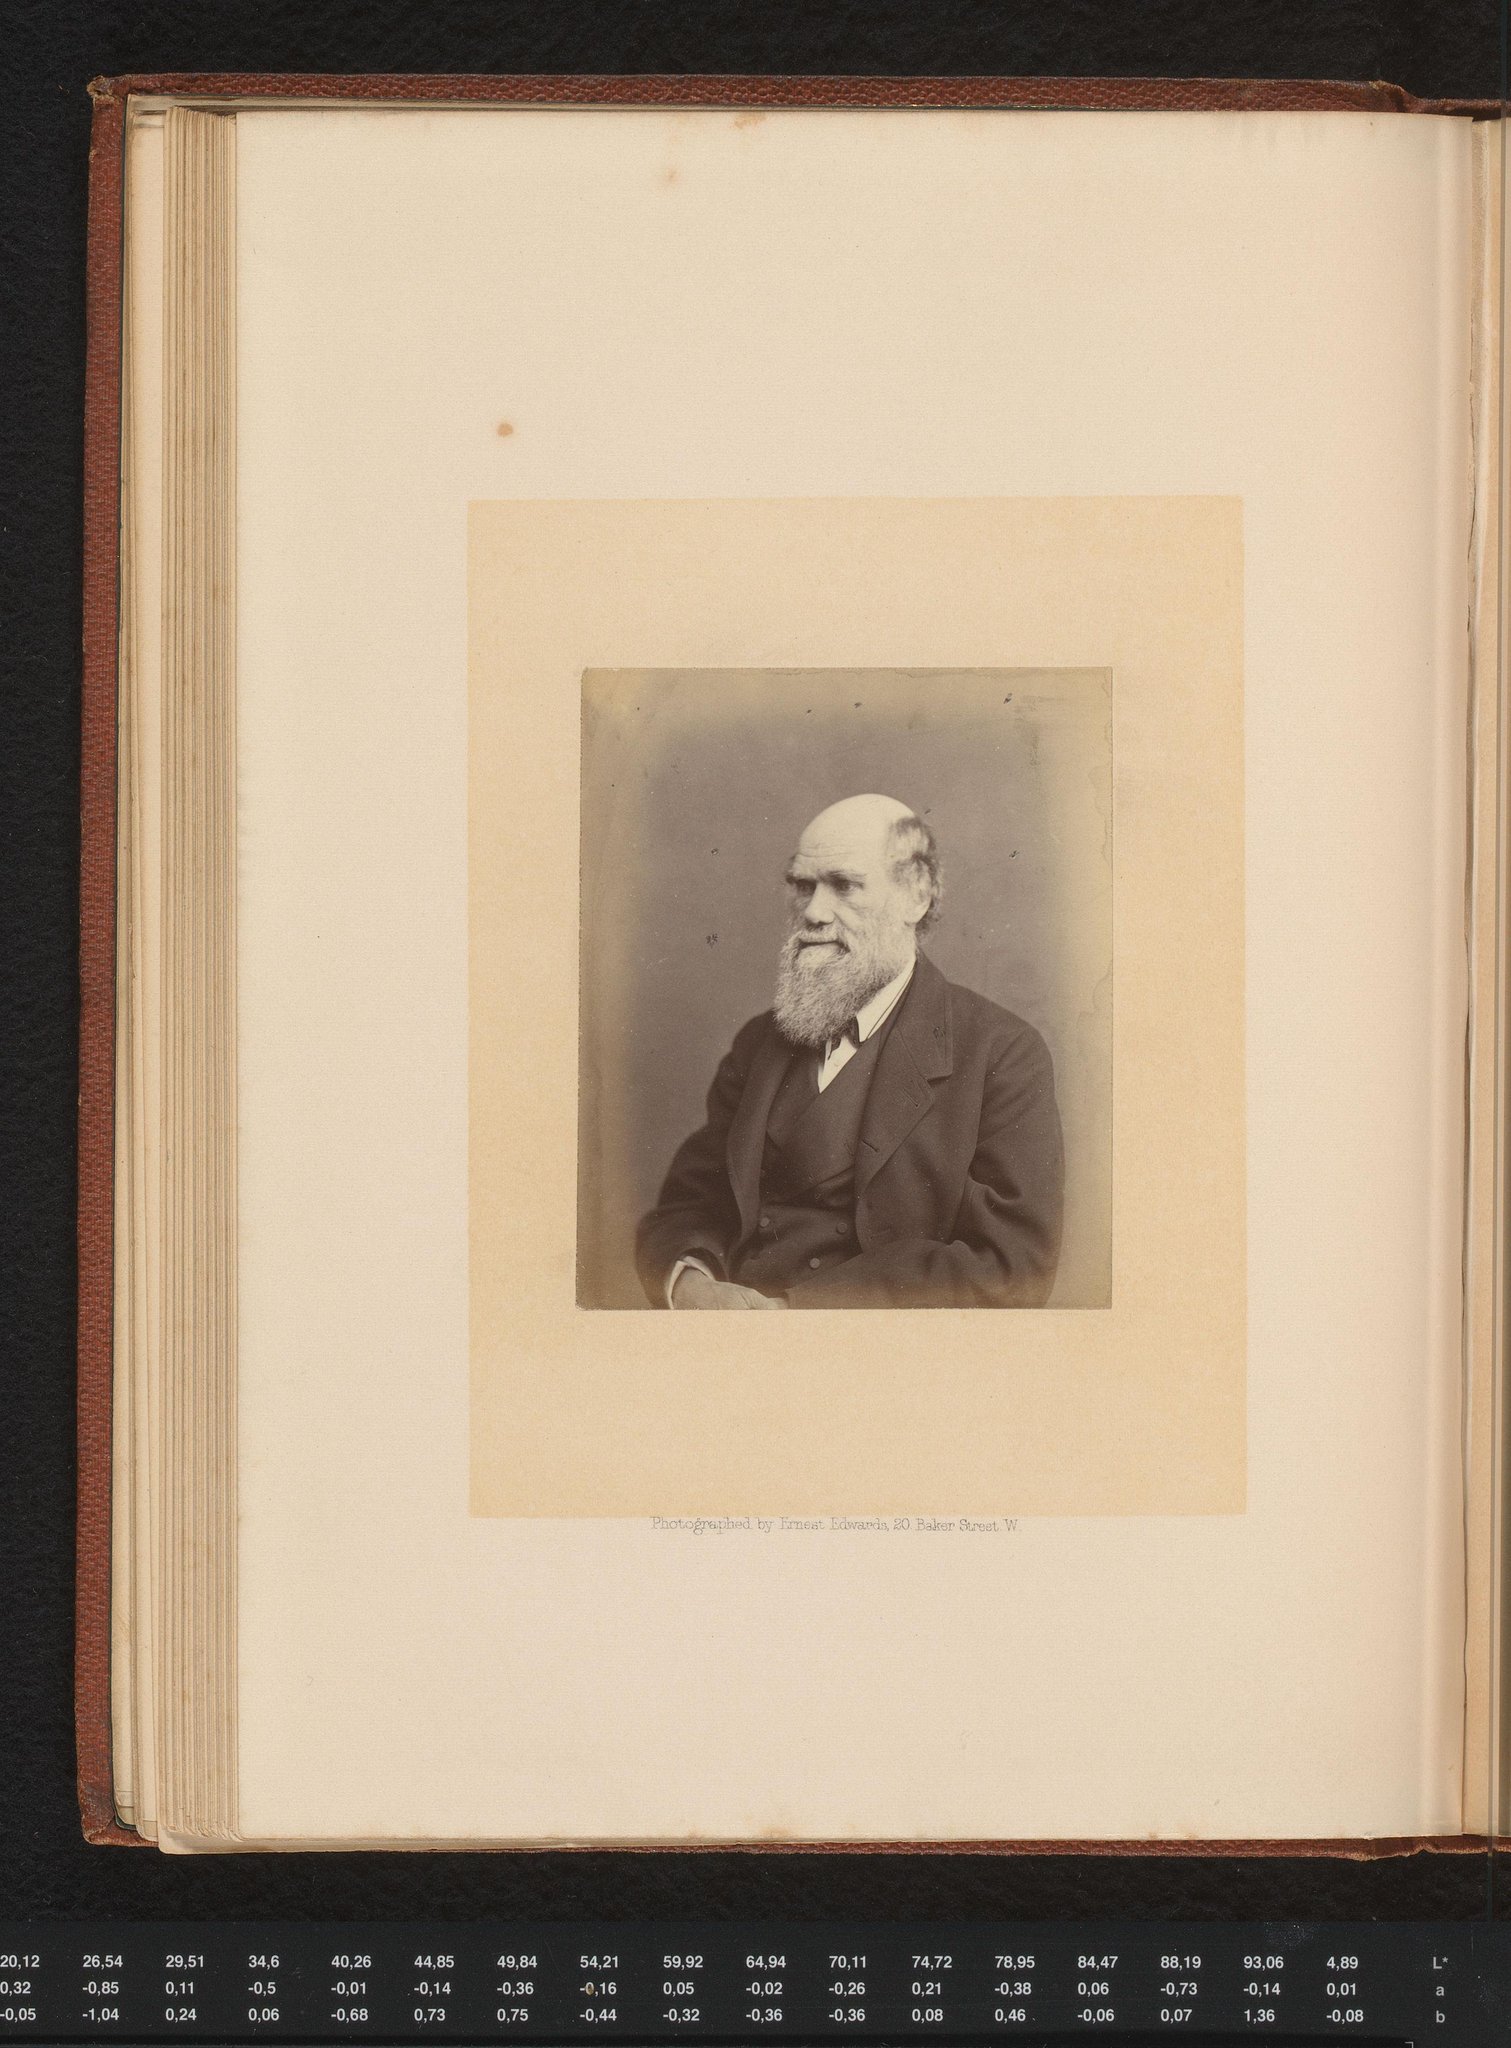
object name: photograph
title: Portret van de bioloog en geoloog Charles Robert Darwin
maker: ernest edwards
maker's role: fotograaf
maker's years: 1837-1903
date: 1861-1866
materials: paper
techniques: albumen print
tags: charles darwin, biology (+ portrait of scholar, scientist)